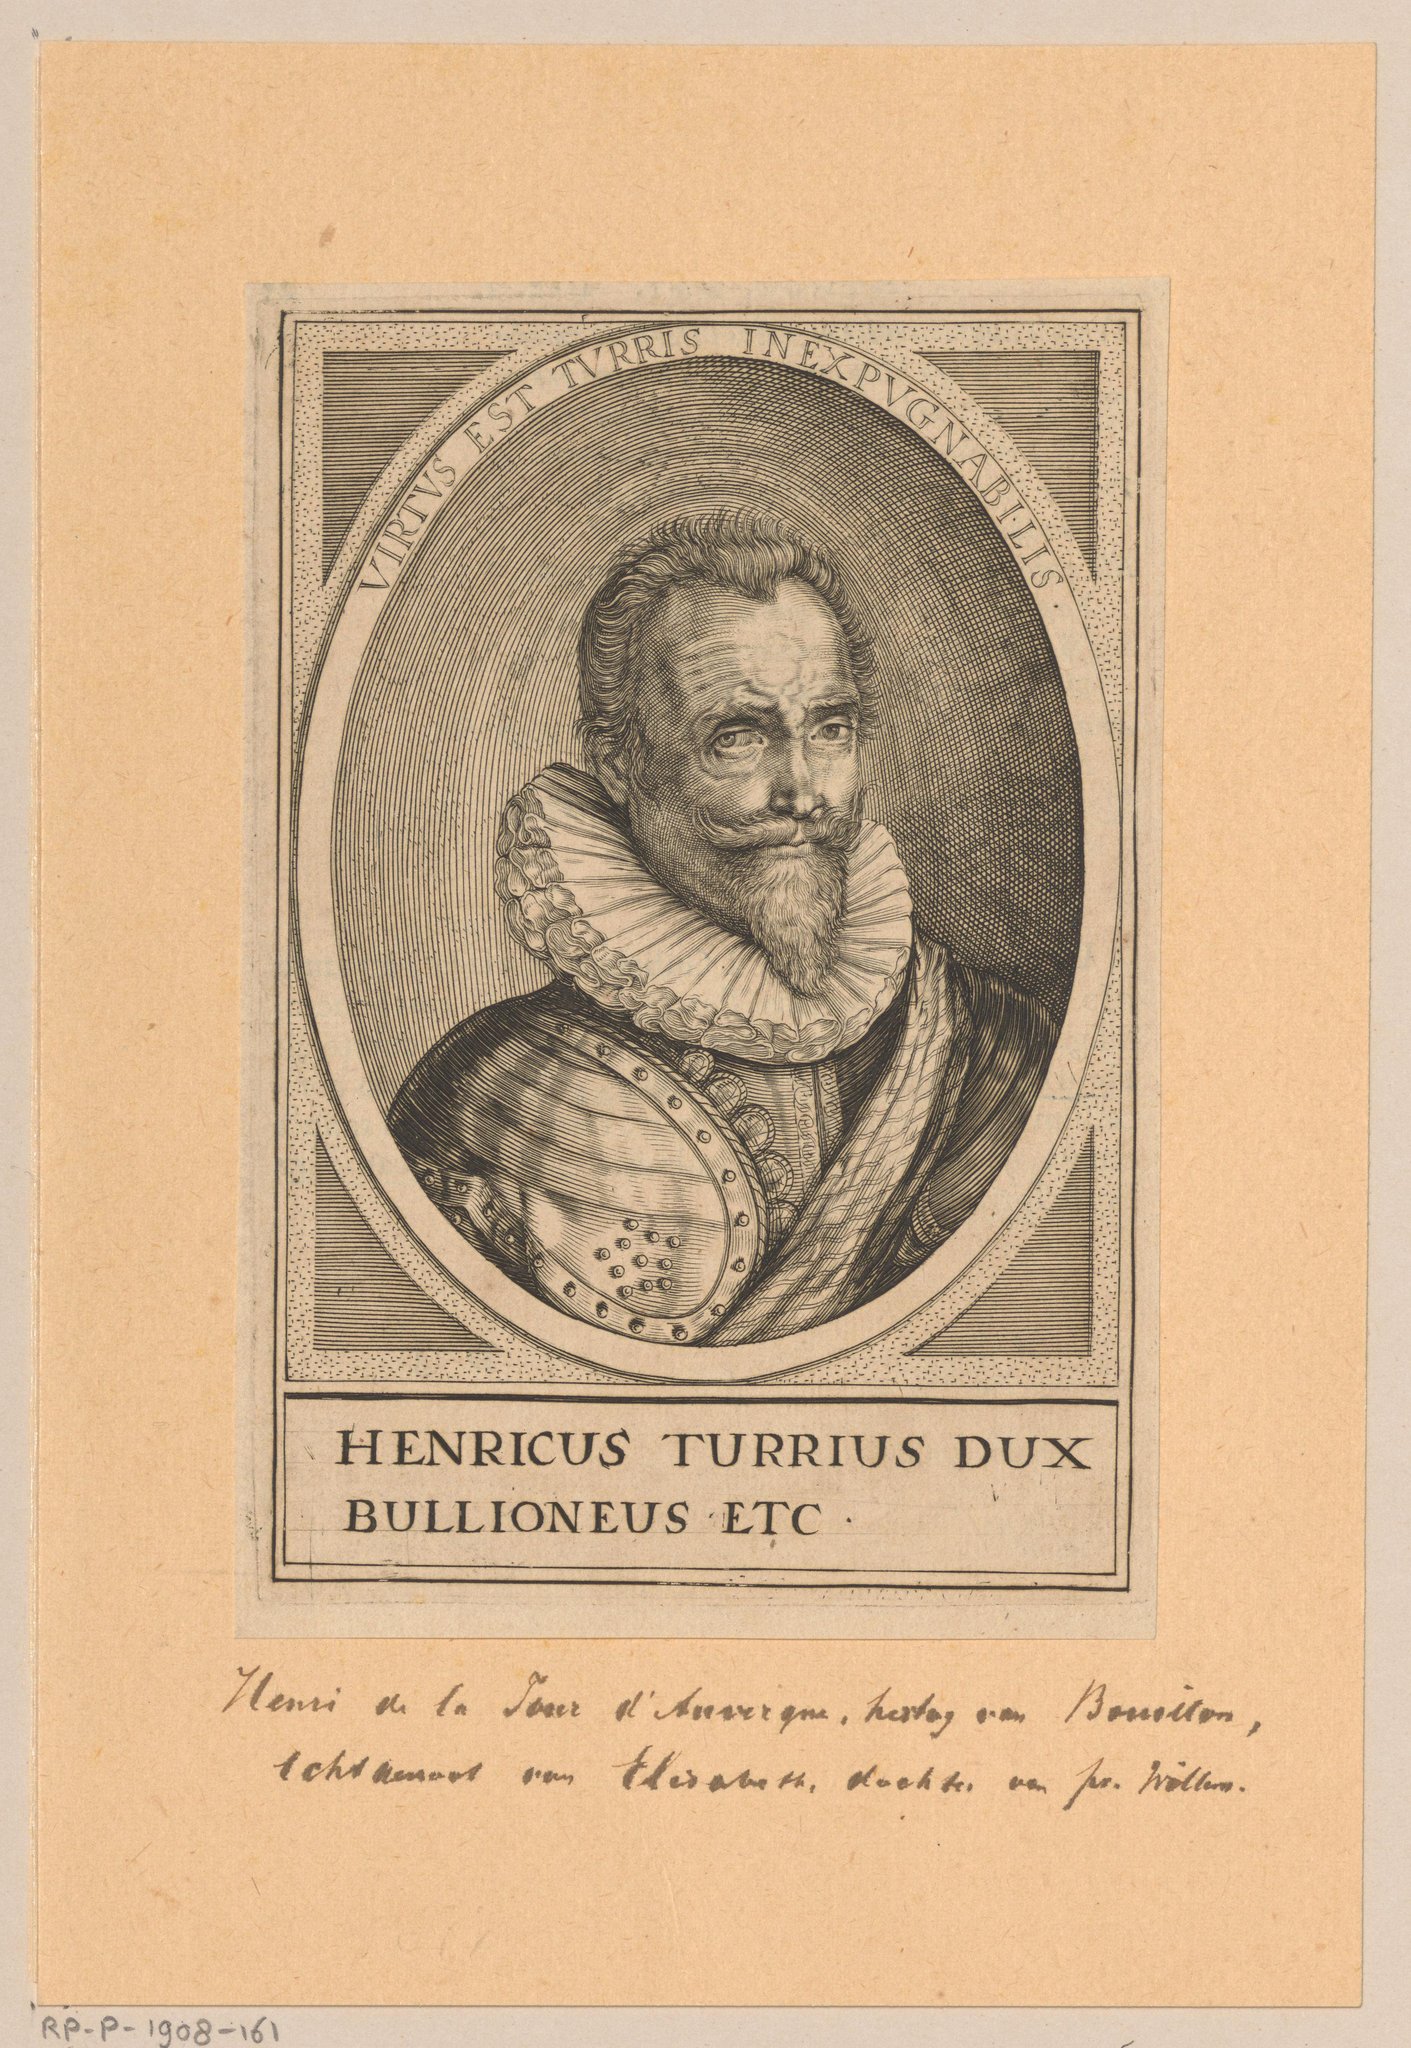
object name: book illustration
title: Portret van Hendrik van Bouillon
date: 1625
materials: paper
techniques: engraving, letterpress printing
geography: leiden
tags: armour, historical persons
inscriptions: collector's mark: Lugt 2228, inscription: ‘Henri de la Tour d'Auvergne, hertog van Bouillon, echtgenoot van Elisabeth, docht van pr. Willem’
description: Prent uit: Meurs, Jacob van. Athenae Batavae (...). Leiden: Elzevier en Andries Clouck, 1625, p. 30.